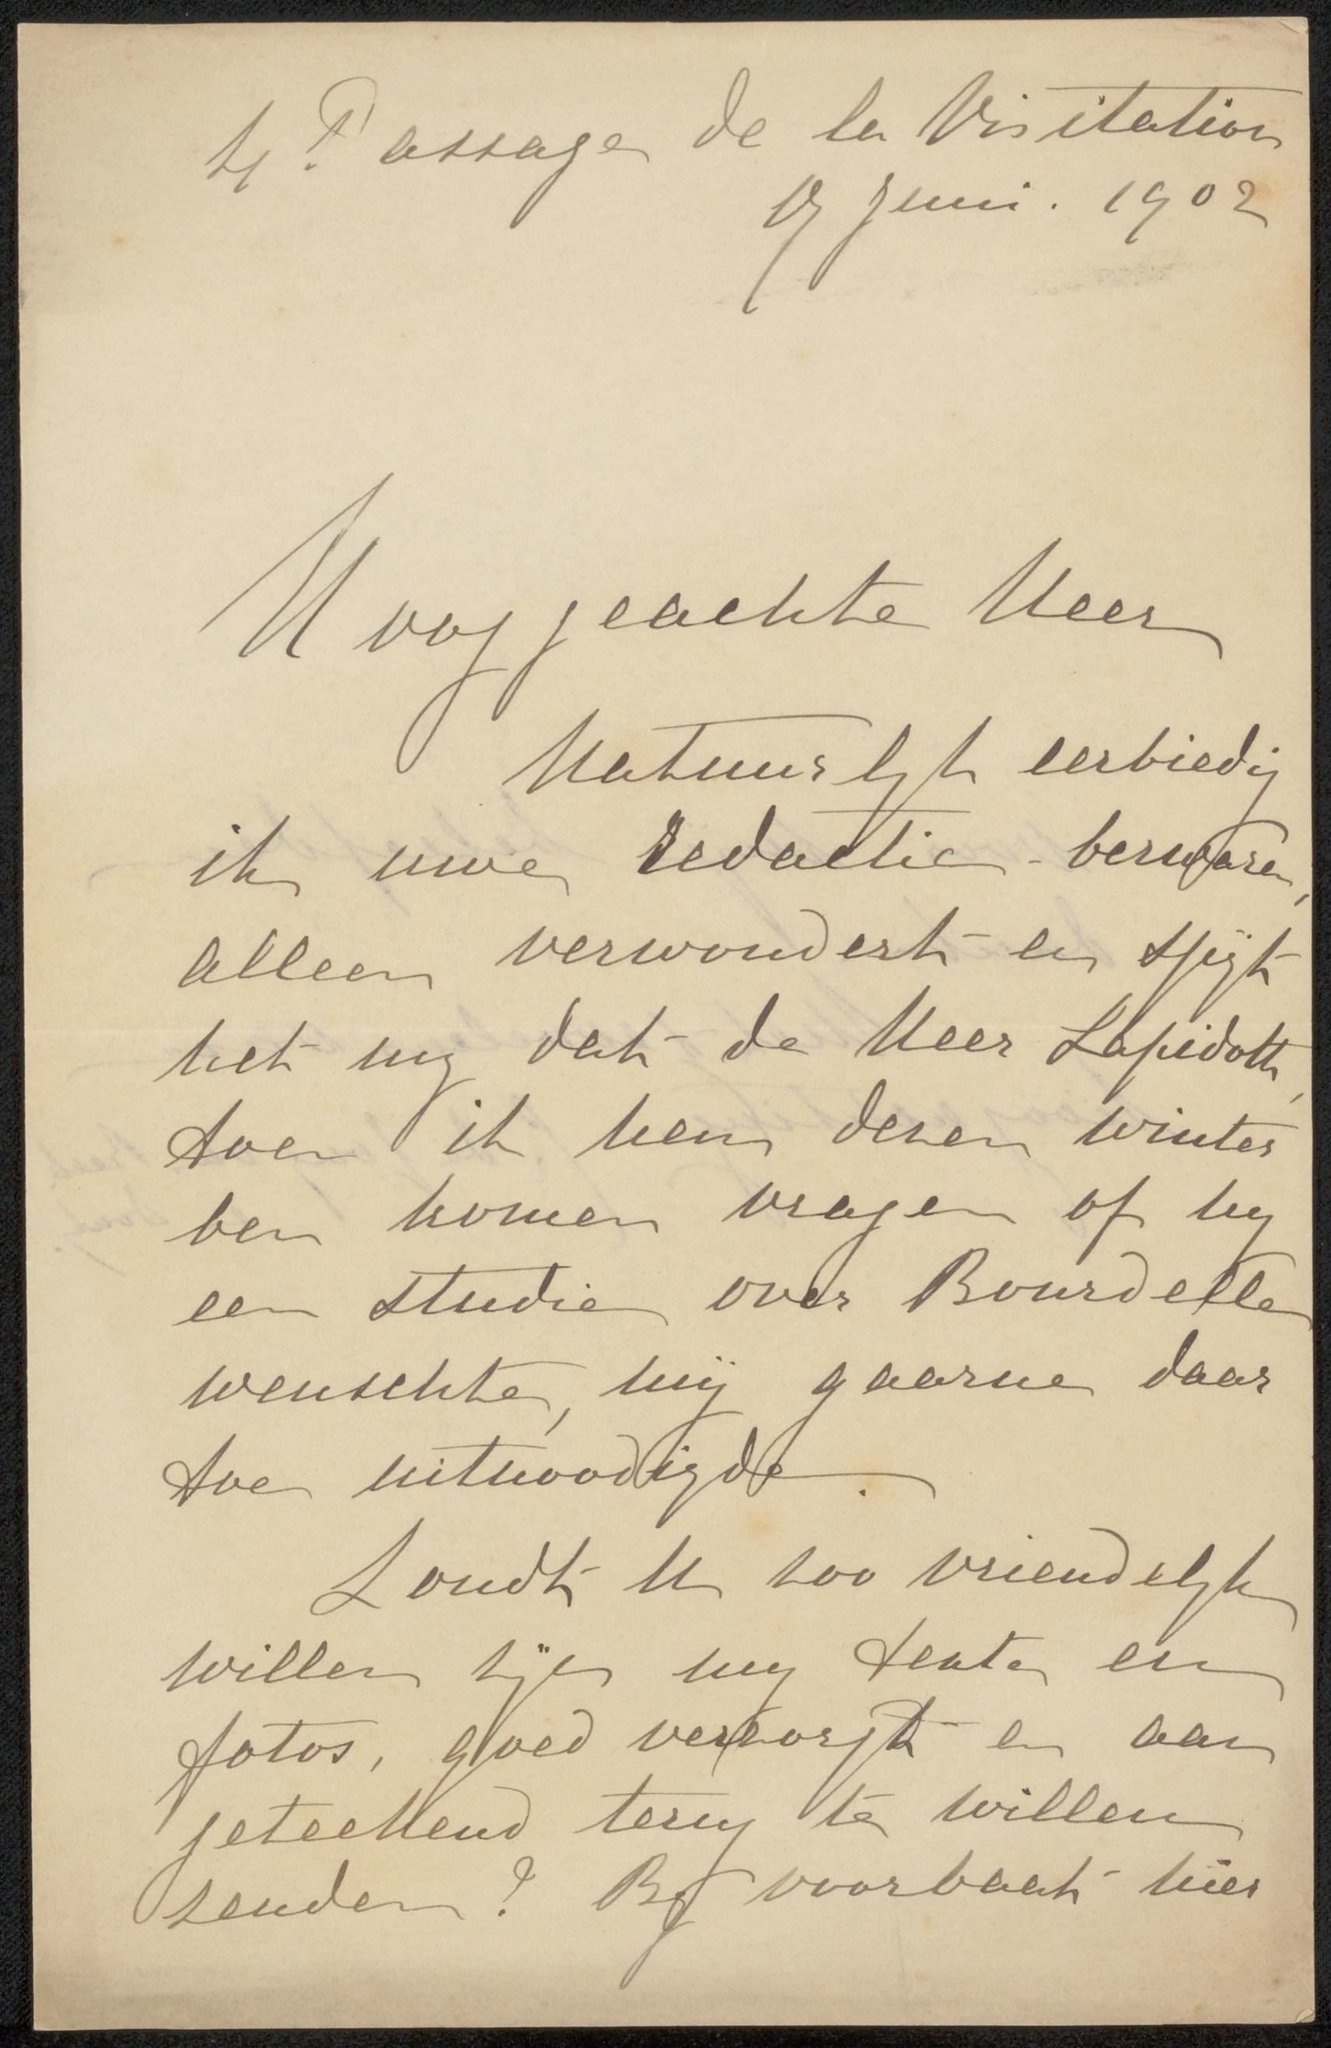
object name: letter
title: Brief aan Philip Zilcken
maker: jonkvrouw cécile de jong van beek en donk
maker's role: schrijver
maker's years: 1866-1944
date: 1902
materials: ink, paper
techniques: pen, writing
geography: paris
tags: draughtsman, sculptor, antoine bourdelle, frits lapidoth, painter, philip zilcken, photography, cinematography, printed matter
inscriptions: collector's mark: ‘RPK’